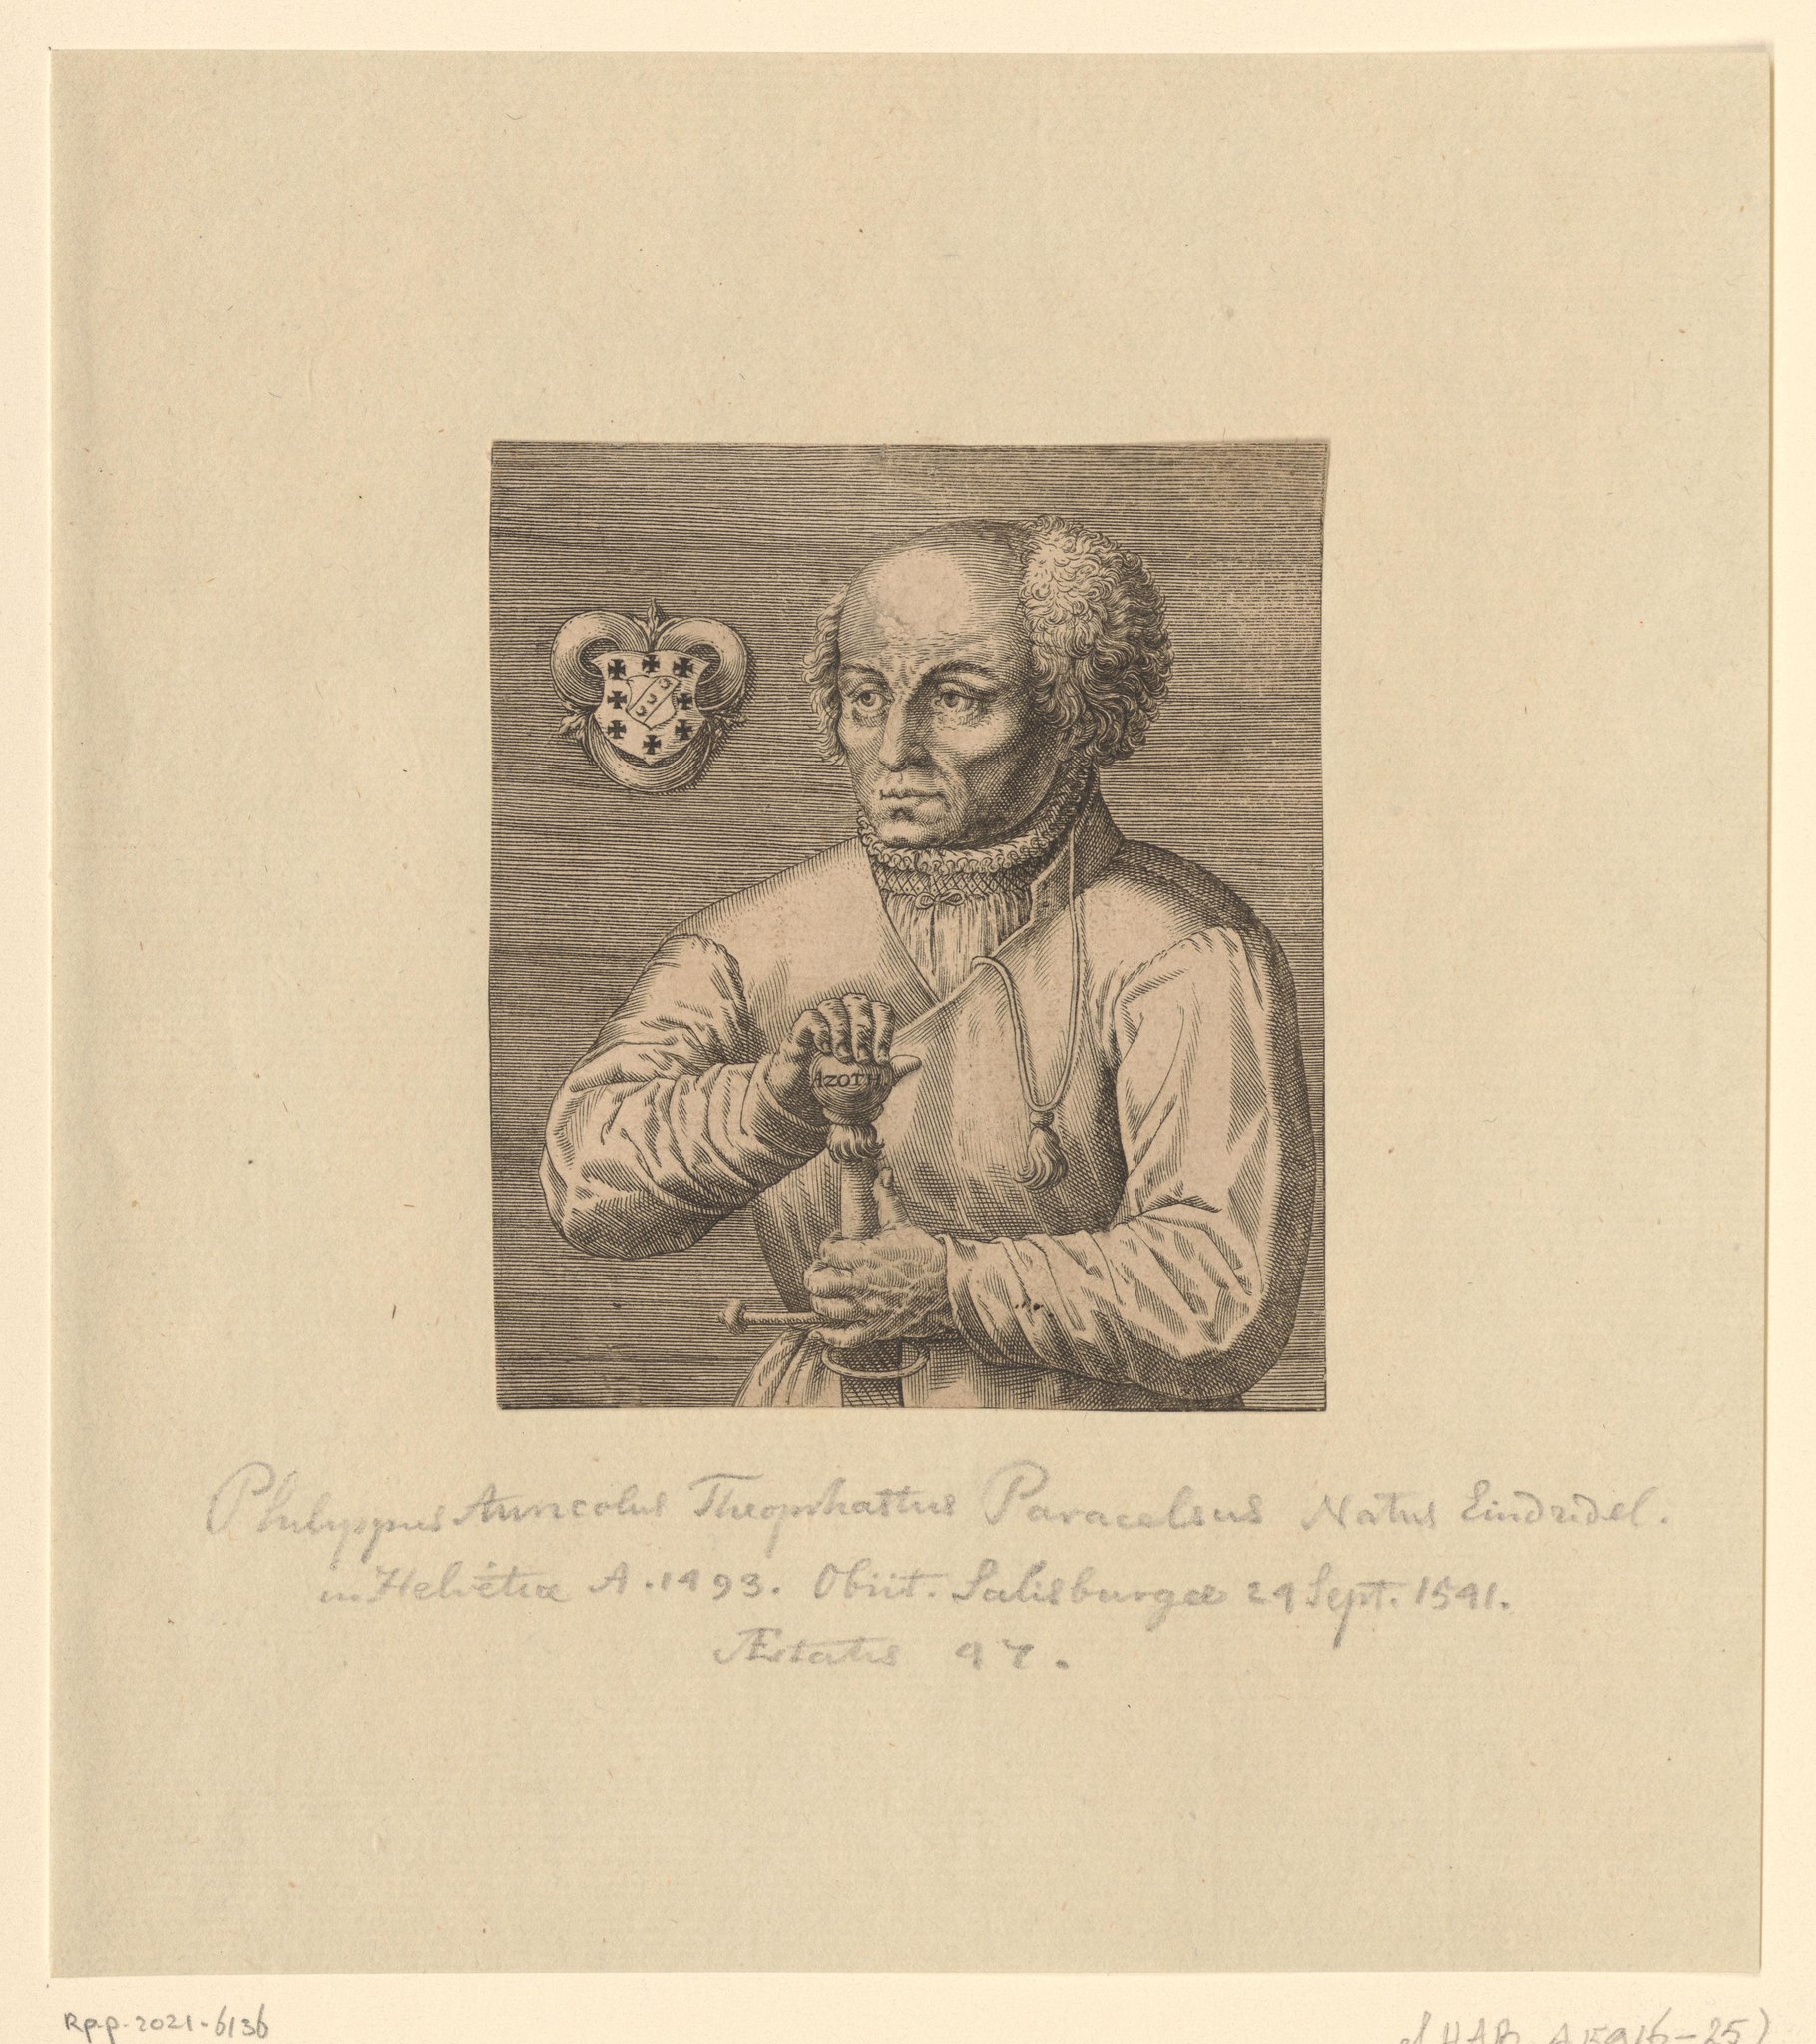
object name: print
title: Doctorum aliquot virorum effigies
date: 1646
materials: paper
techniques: engraving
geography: amsterdam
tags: adult man, historical persons, hacking and thrusting weapons: sword, armorial bearing, heraldry